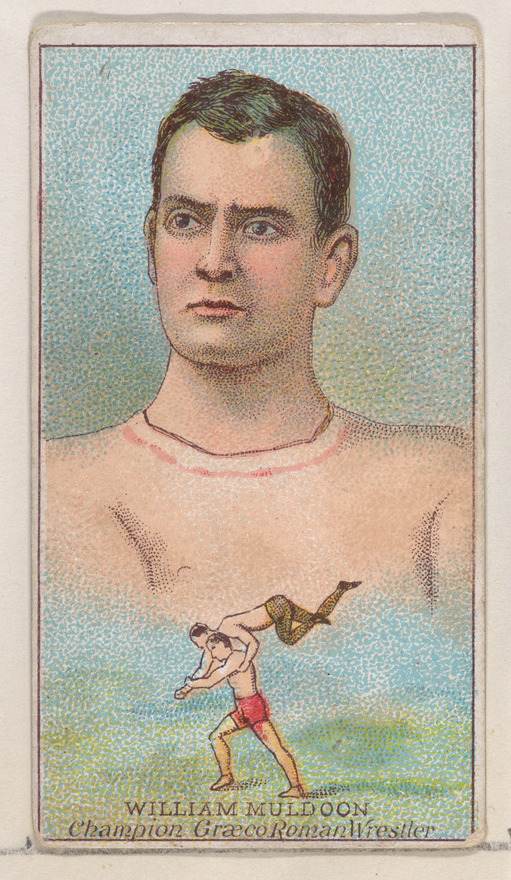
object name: print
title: William Muldoon, Champion Grœco Roman Wrestler, from the Champions of Games and Sports series (N184, Type 2) issued by W.S. Kimball & Co.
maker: w.s. kimball & co.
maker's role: publisher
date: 1887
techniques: color lithograph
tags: men,athletes,wrestling